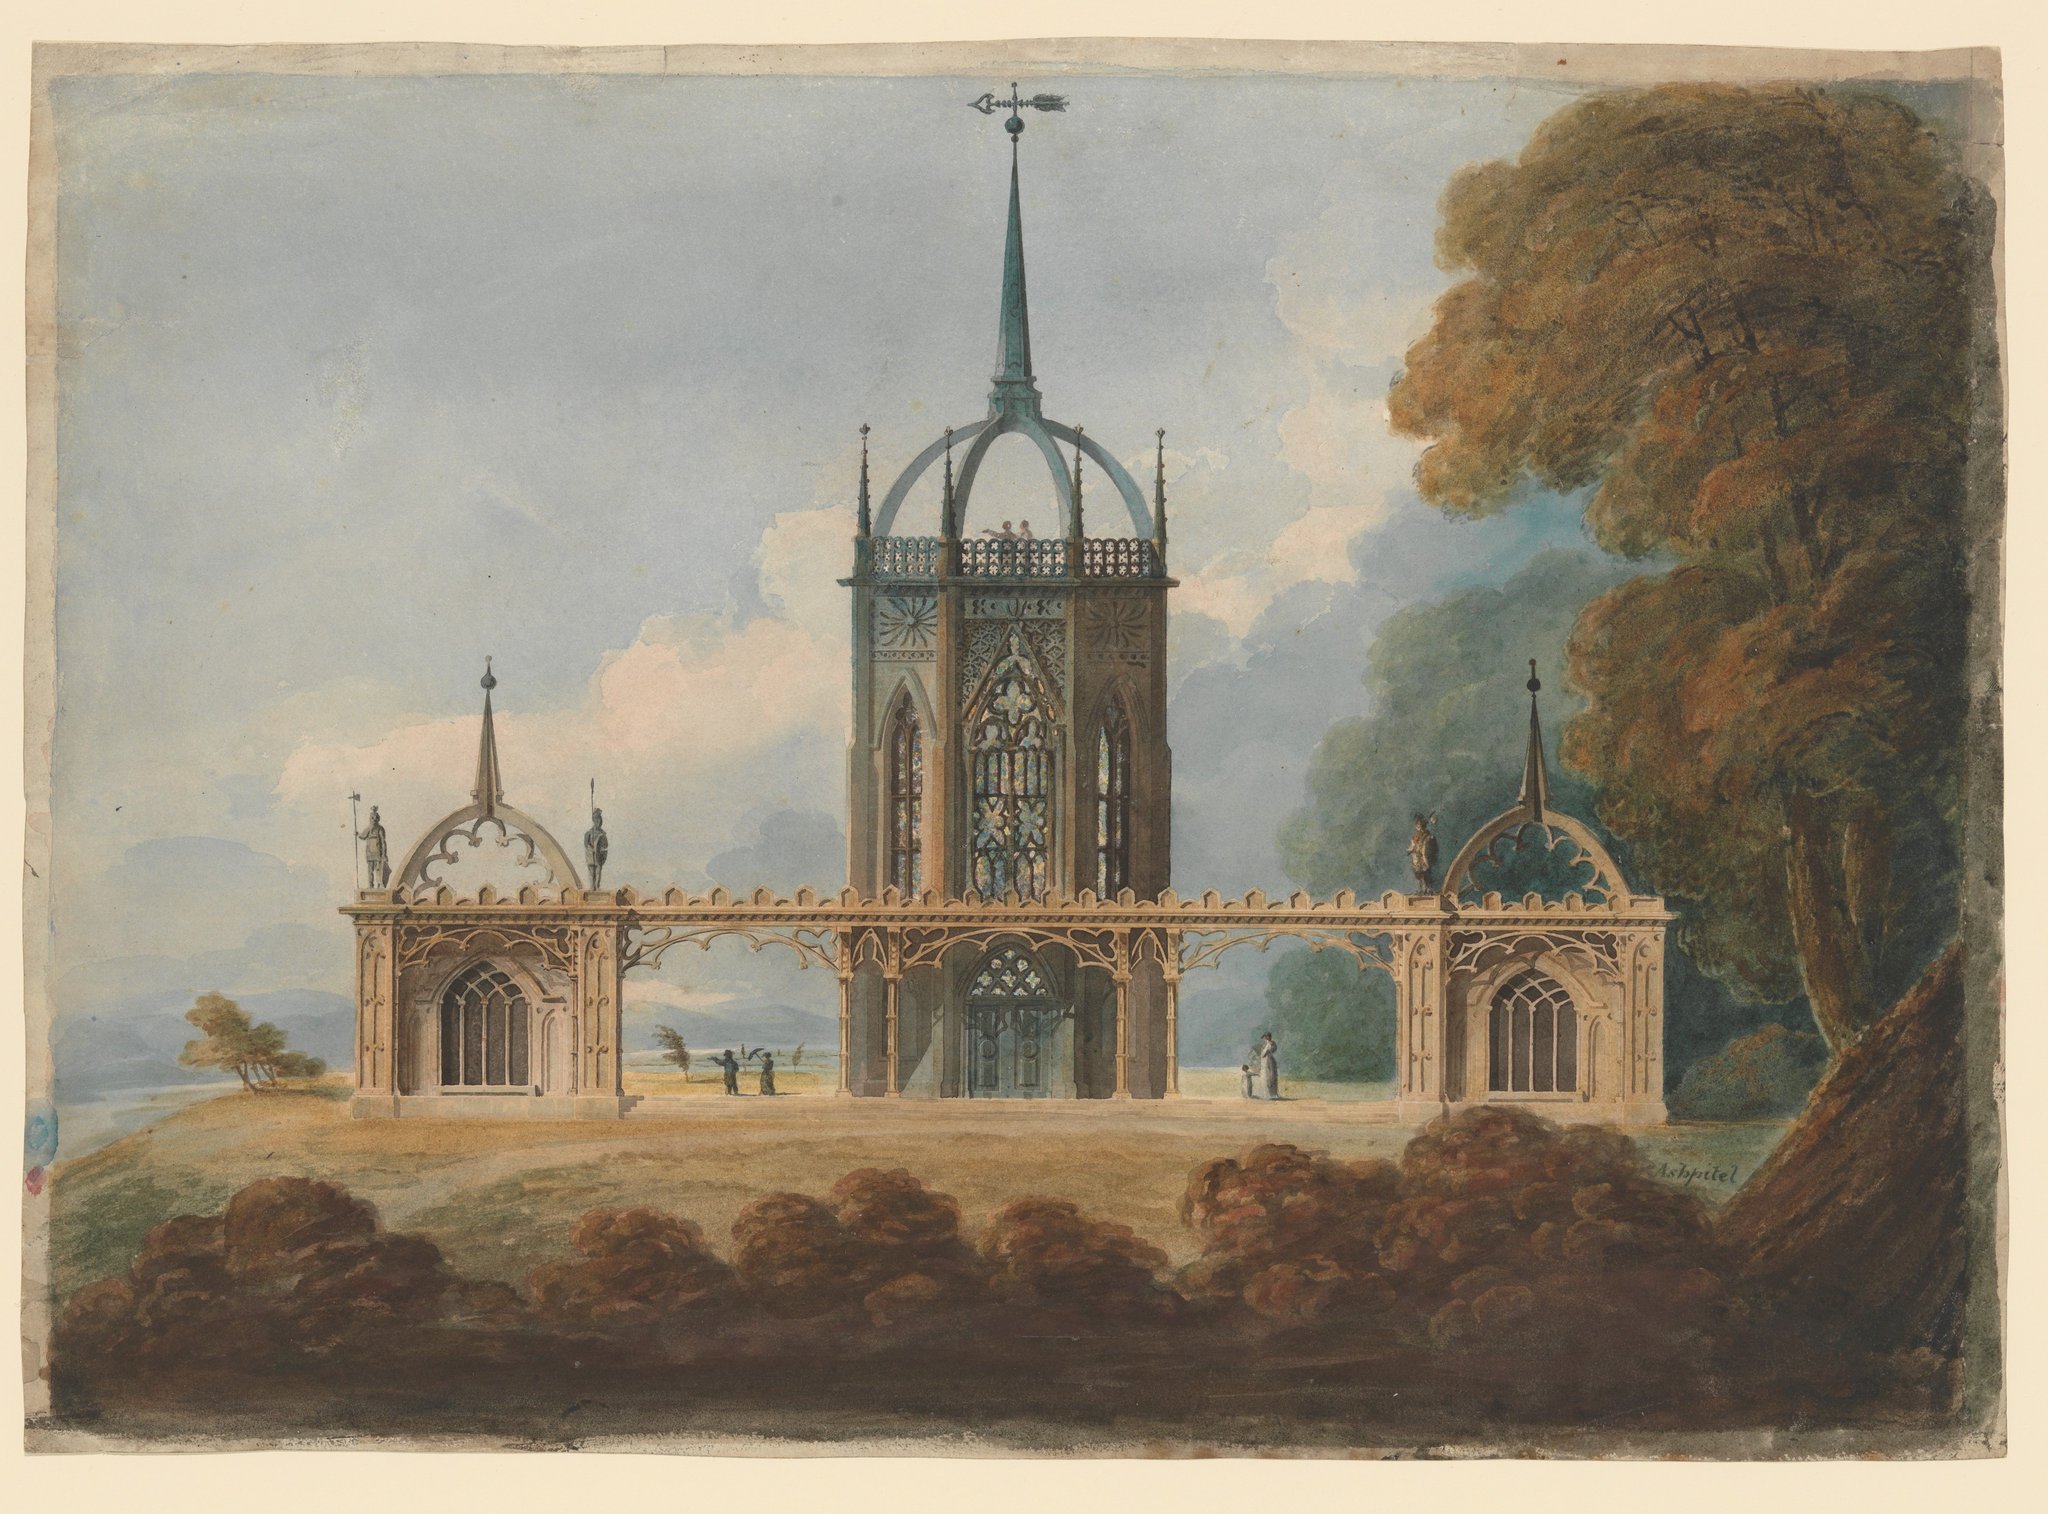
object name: drawing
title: Design for a Gothic "Belle Vue"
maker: william hurst ashpitel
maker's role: artist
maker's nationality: british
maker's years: 1776-1852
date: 1800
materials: watercolor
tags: architecture,trees